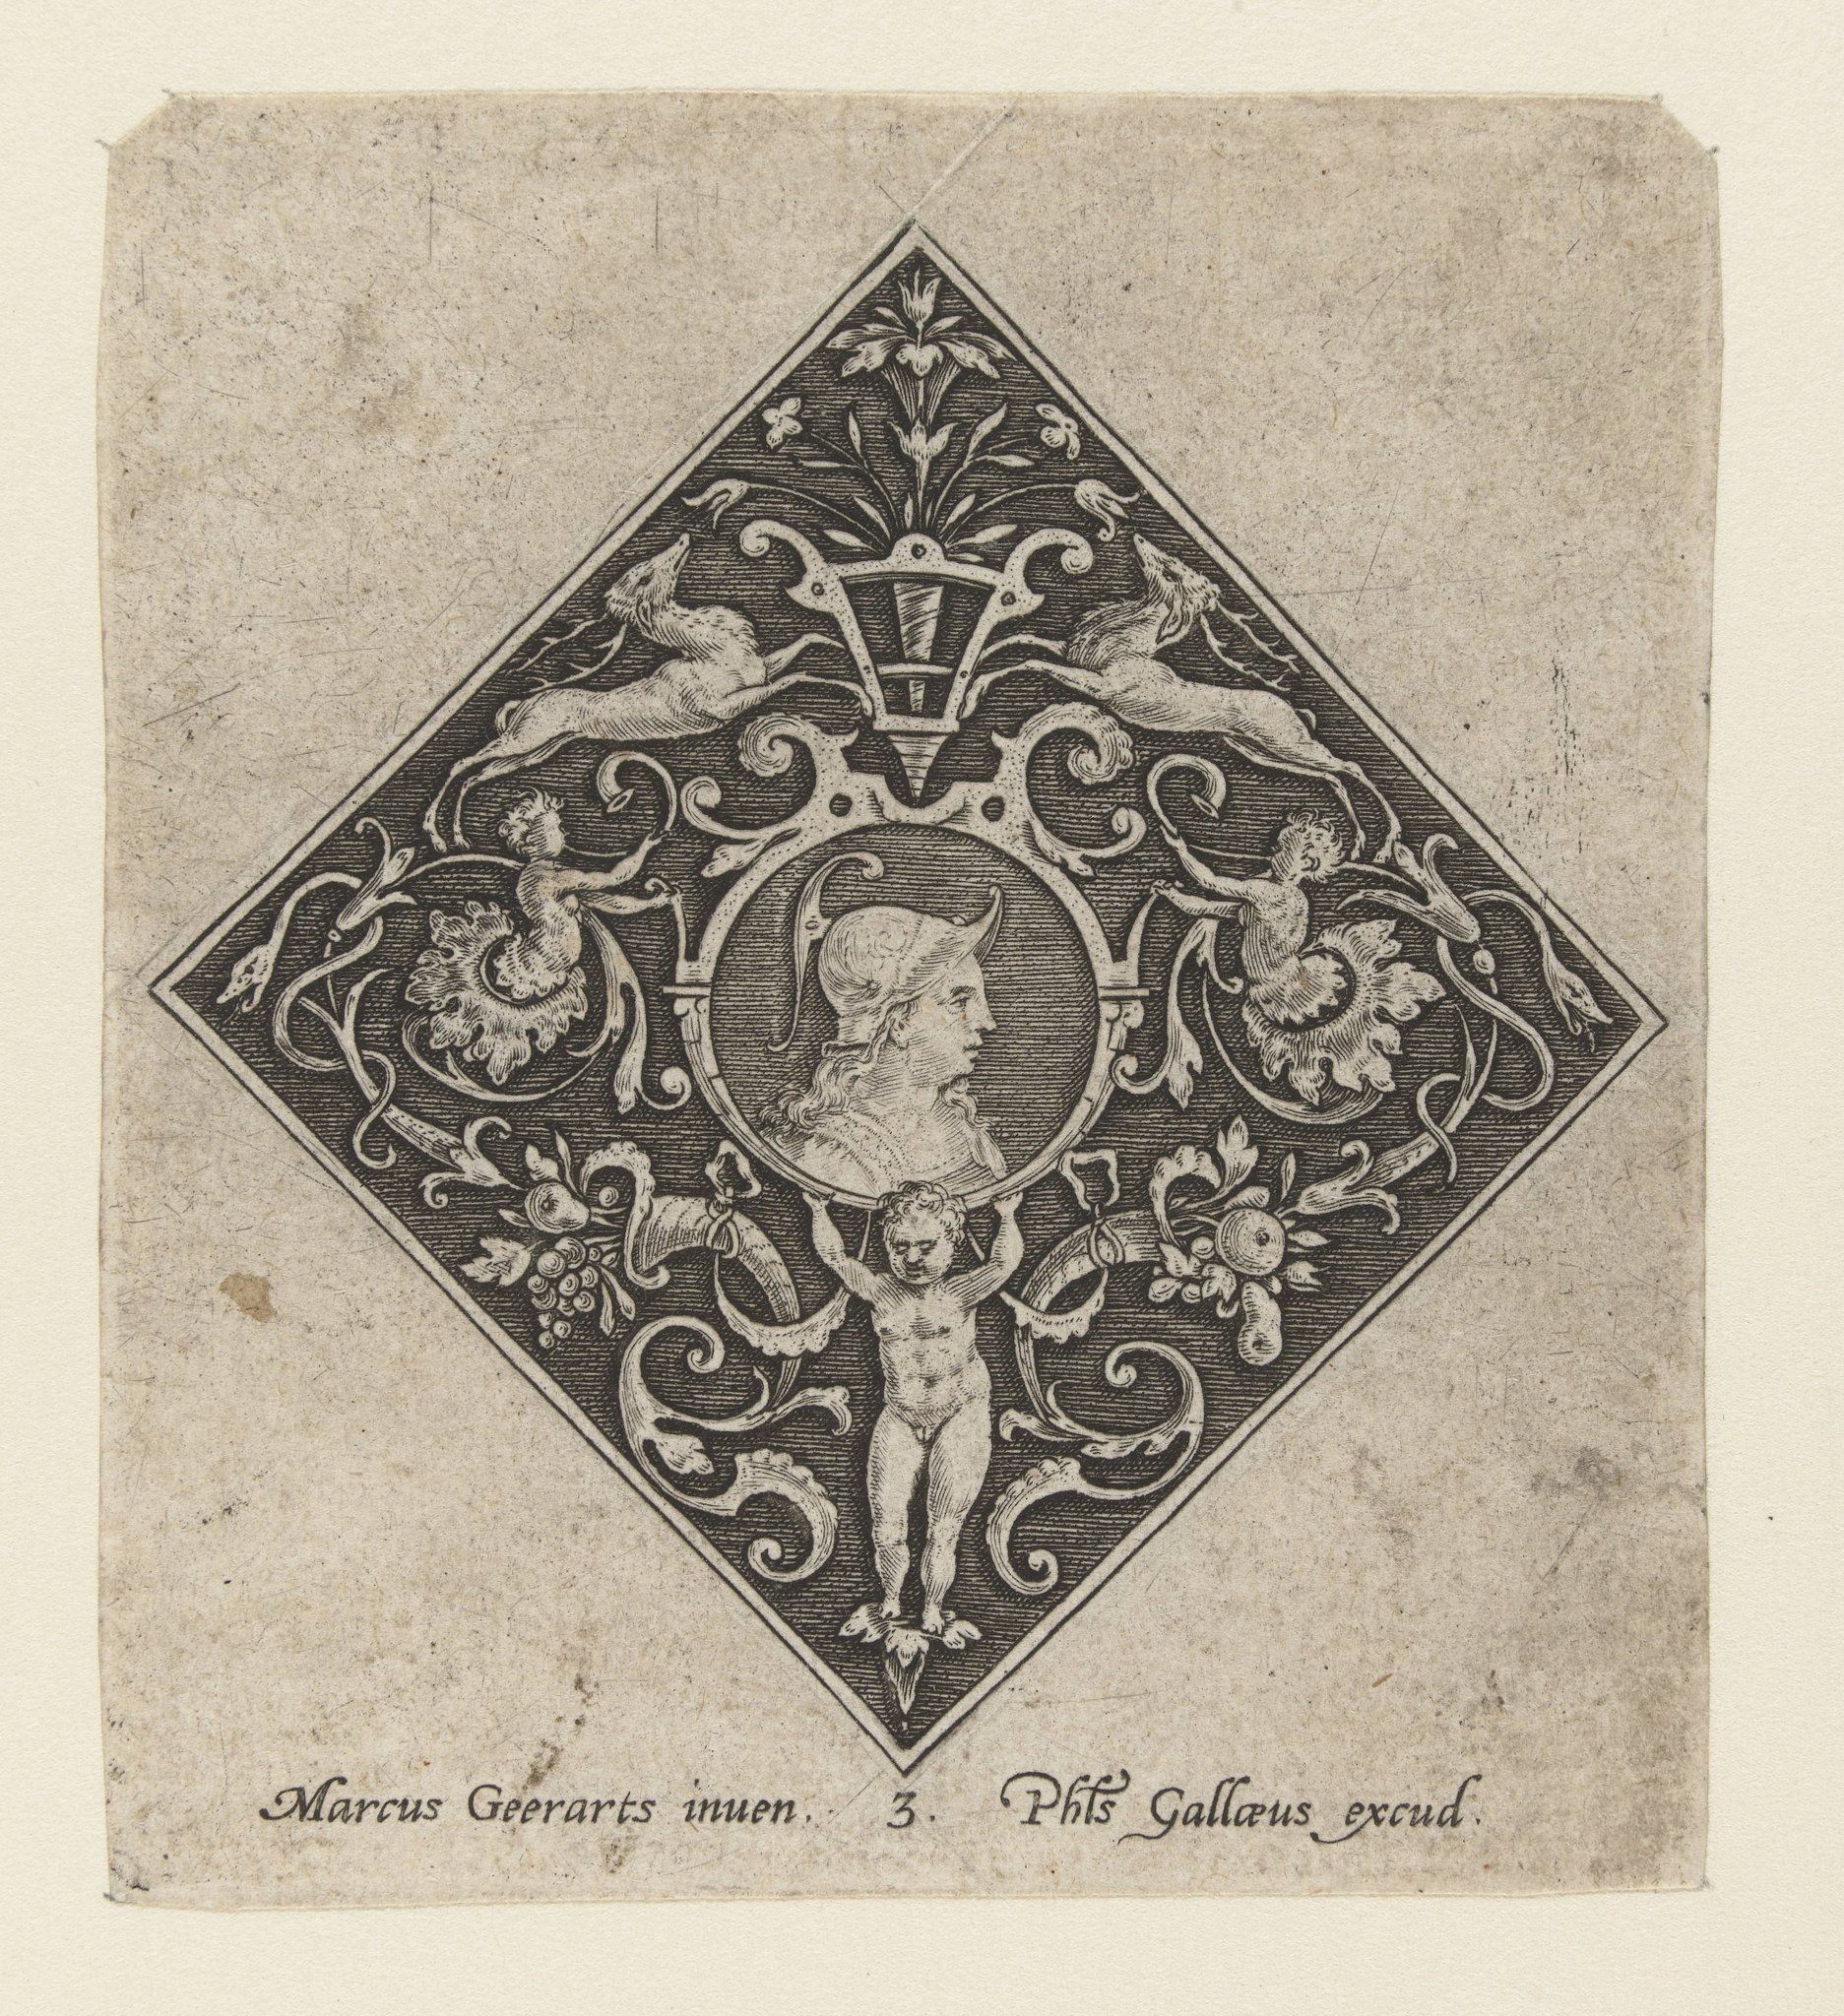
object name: ornament print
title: Vlakdecoraties met grotesken op een gearceerde achtergrond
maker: philips galle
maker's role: print maker, publisher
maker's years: 1537-1612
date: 1547-1612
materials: paper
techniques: engraving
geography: netherlands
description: Blad 3 van 5 genummerde bladen uit een serie van 12. Rond het medaillon slingeren zich grotesken met bovenaan twee springende herten.